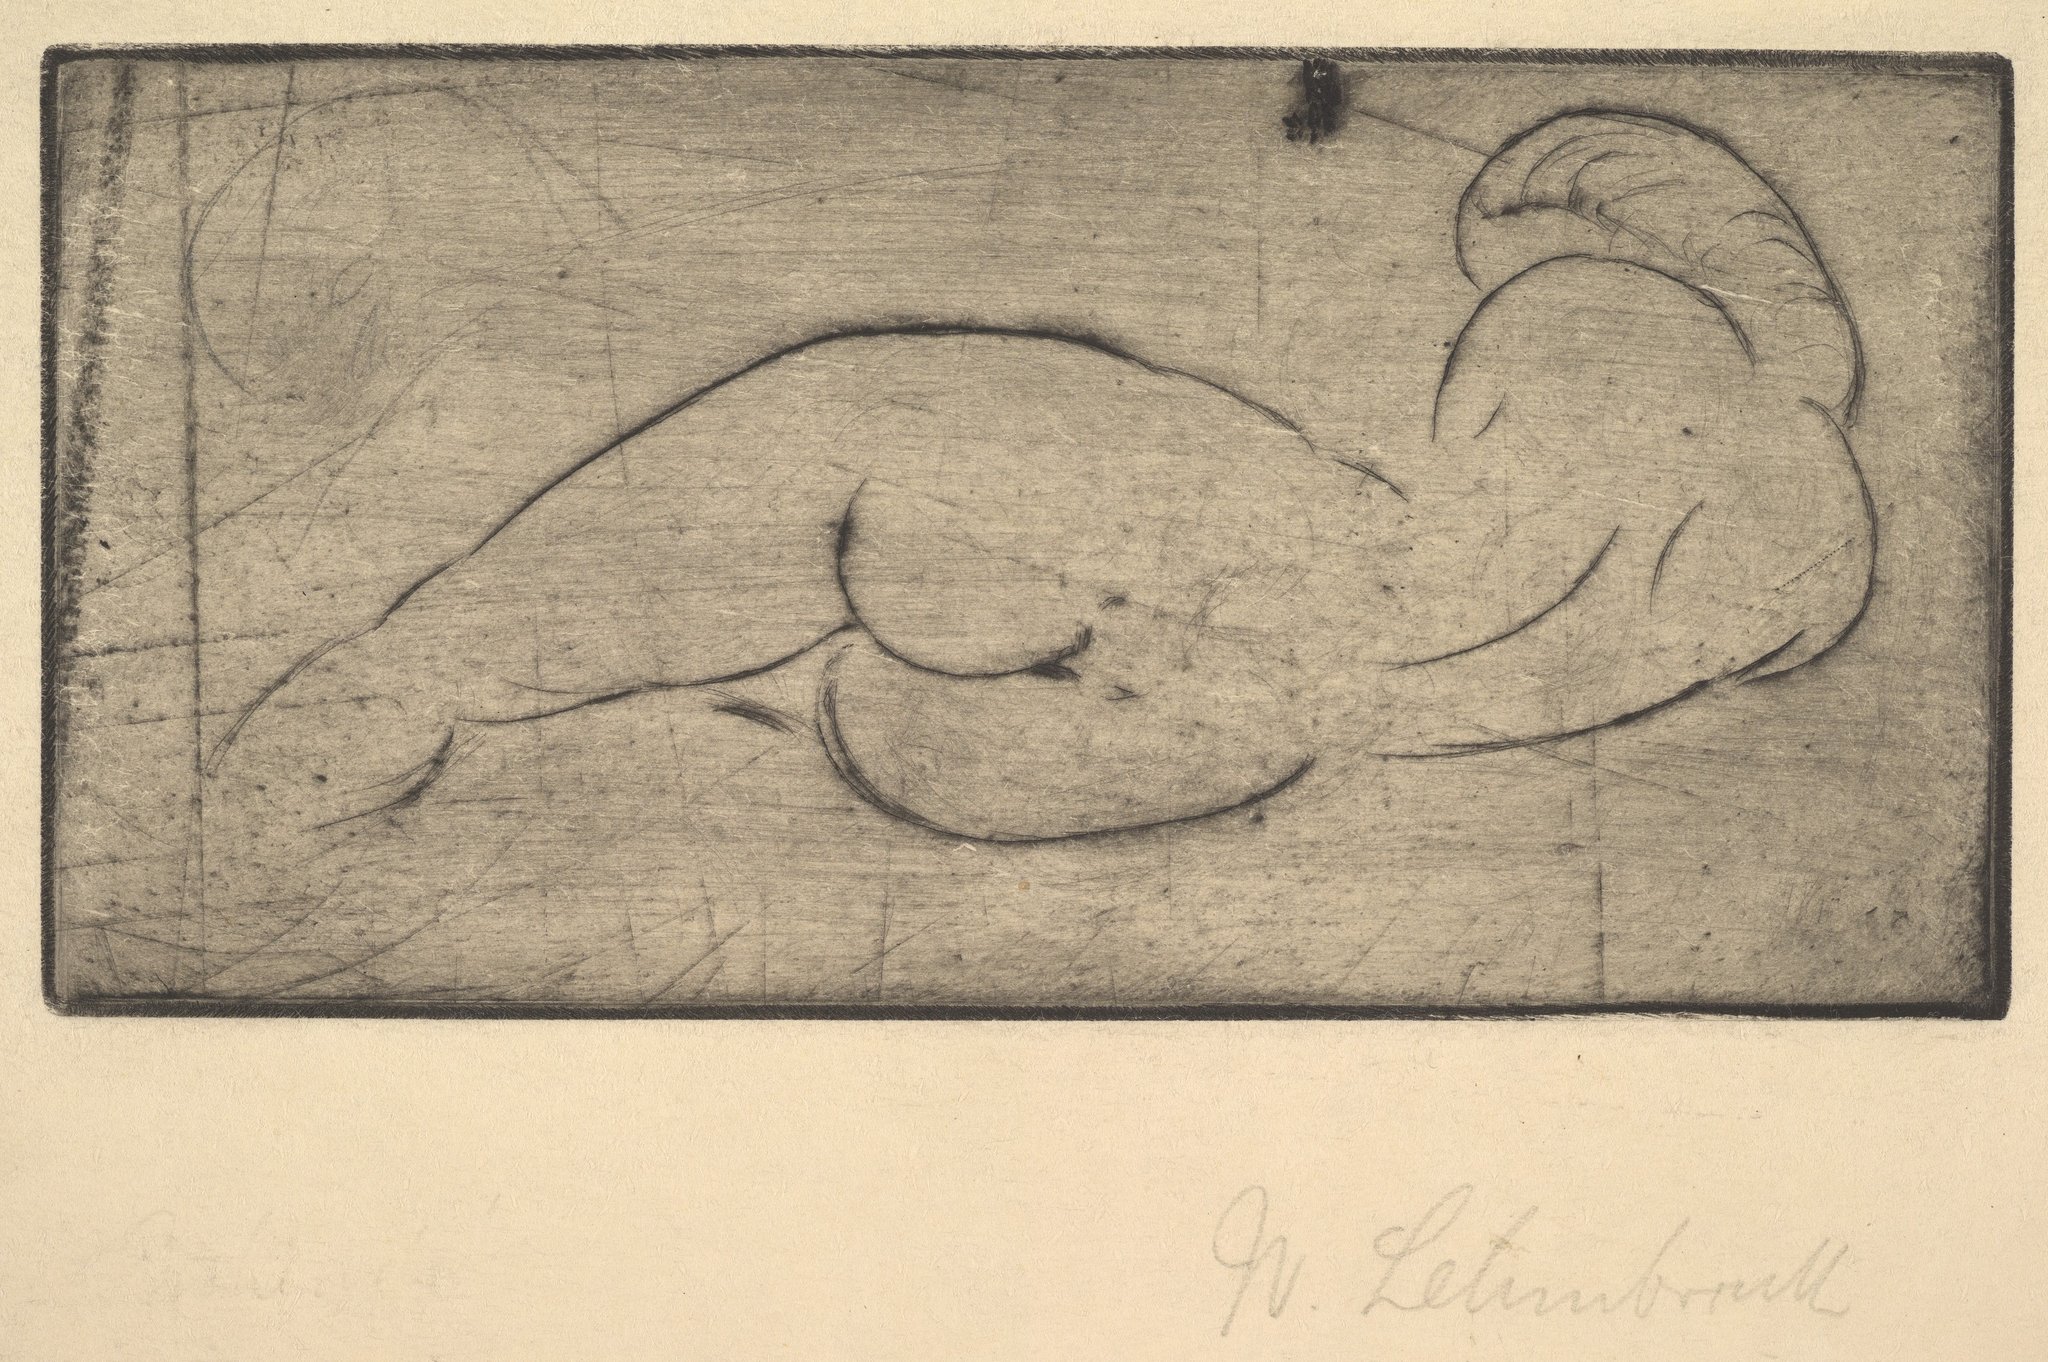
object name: print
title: Repose (Ruhende vom Rücken)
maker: wilhelm lehmbruck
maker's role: artist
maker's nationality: german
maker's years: 1881-1919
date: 1913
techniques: drypoint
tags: female nudes